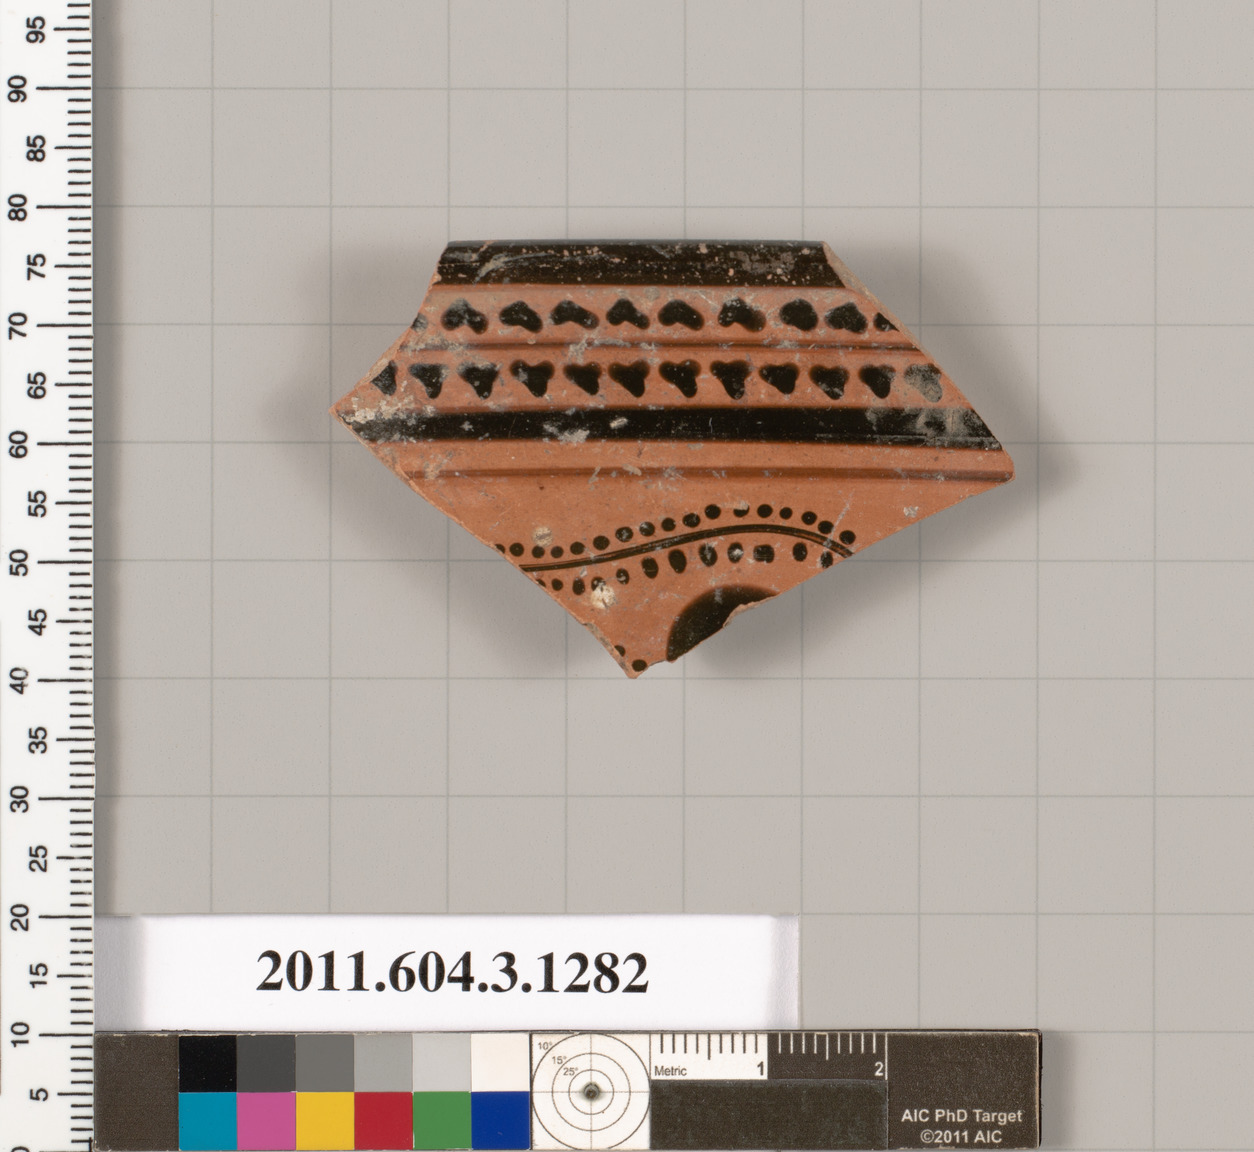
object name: skyphos fragment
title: Terracotta rim fragment of a skyphos (deep drinking cup)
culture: greek, attic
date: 500 BCE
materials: terracotta